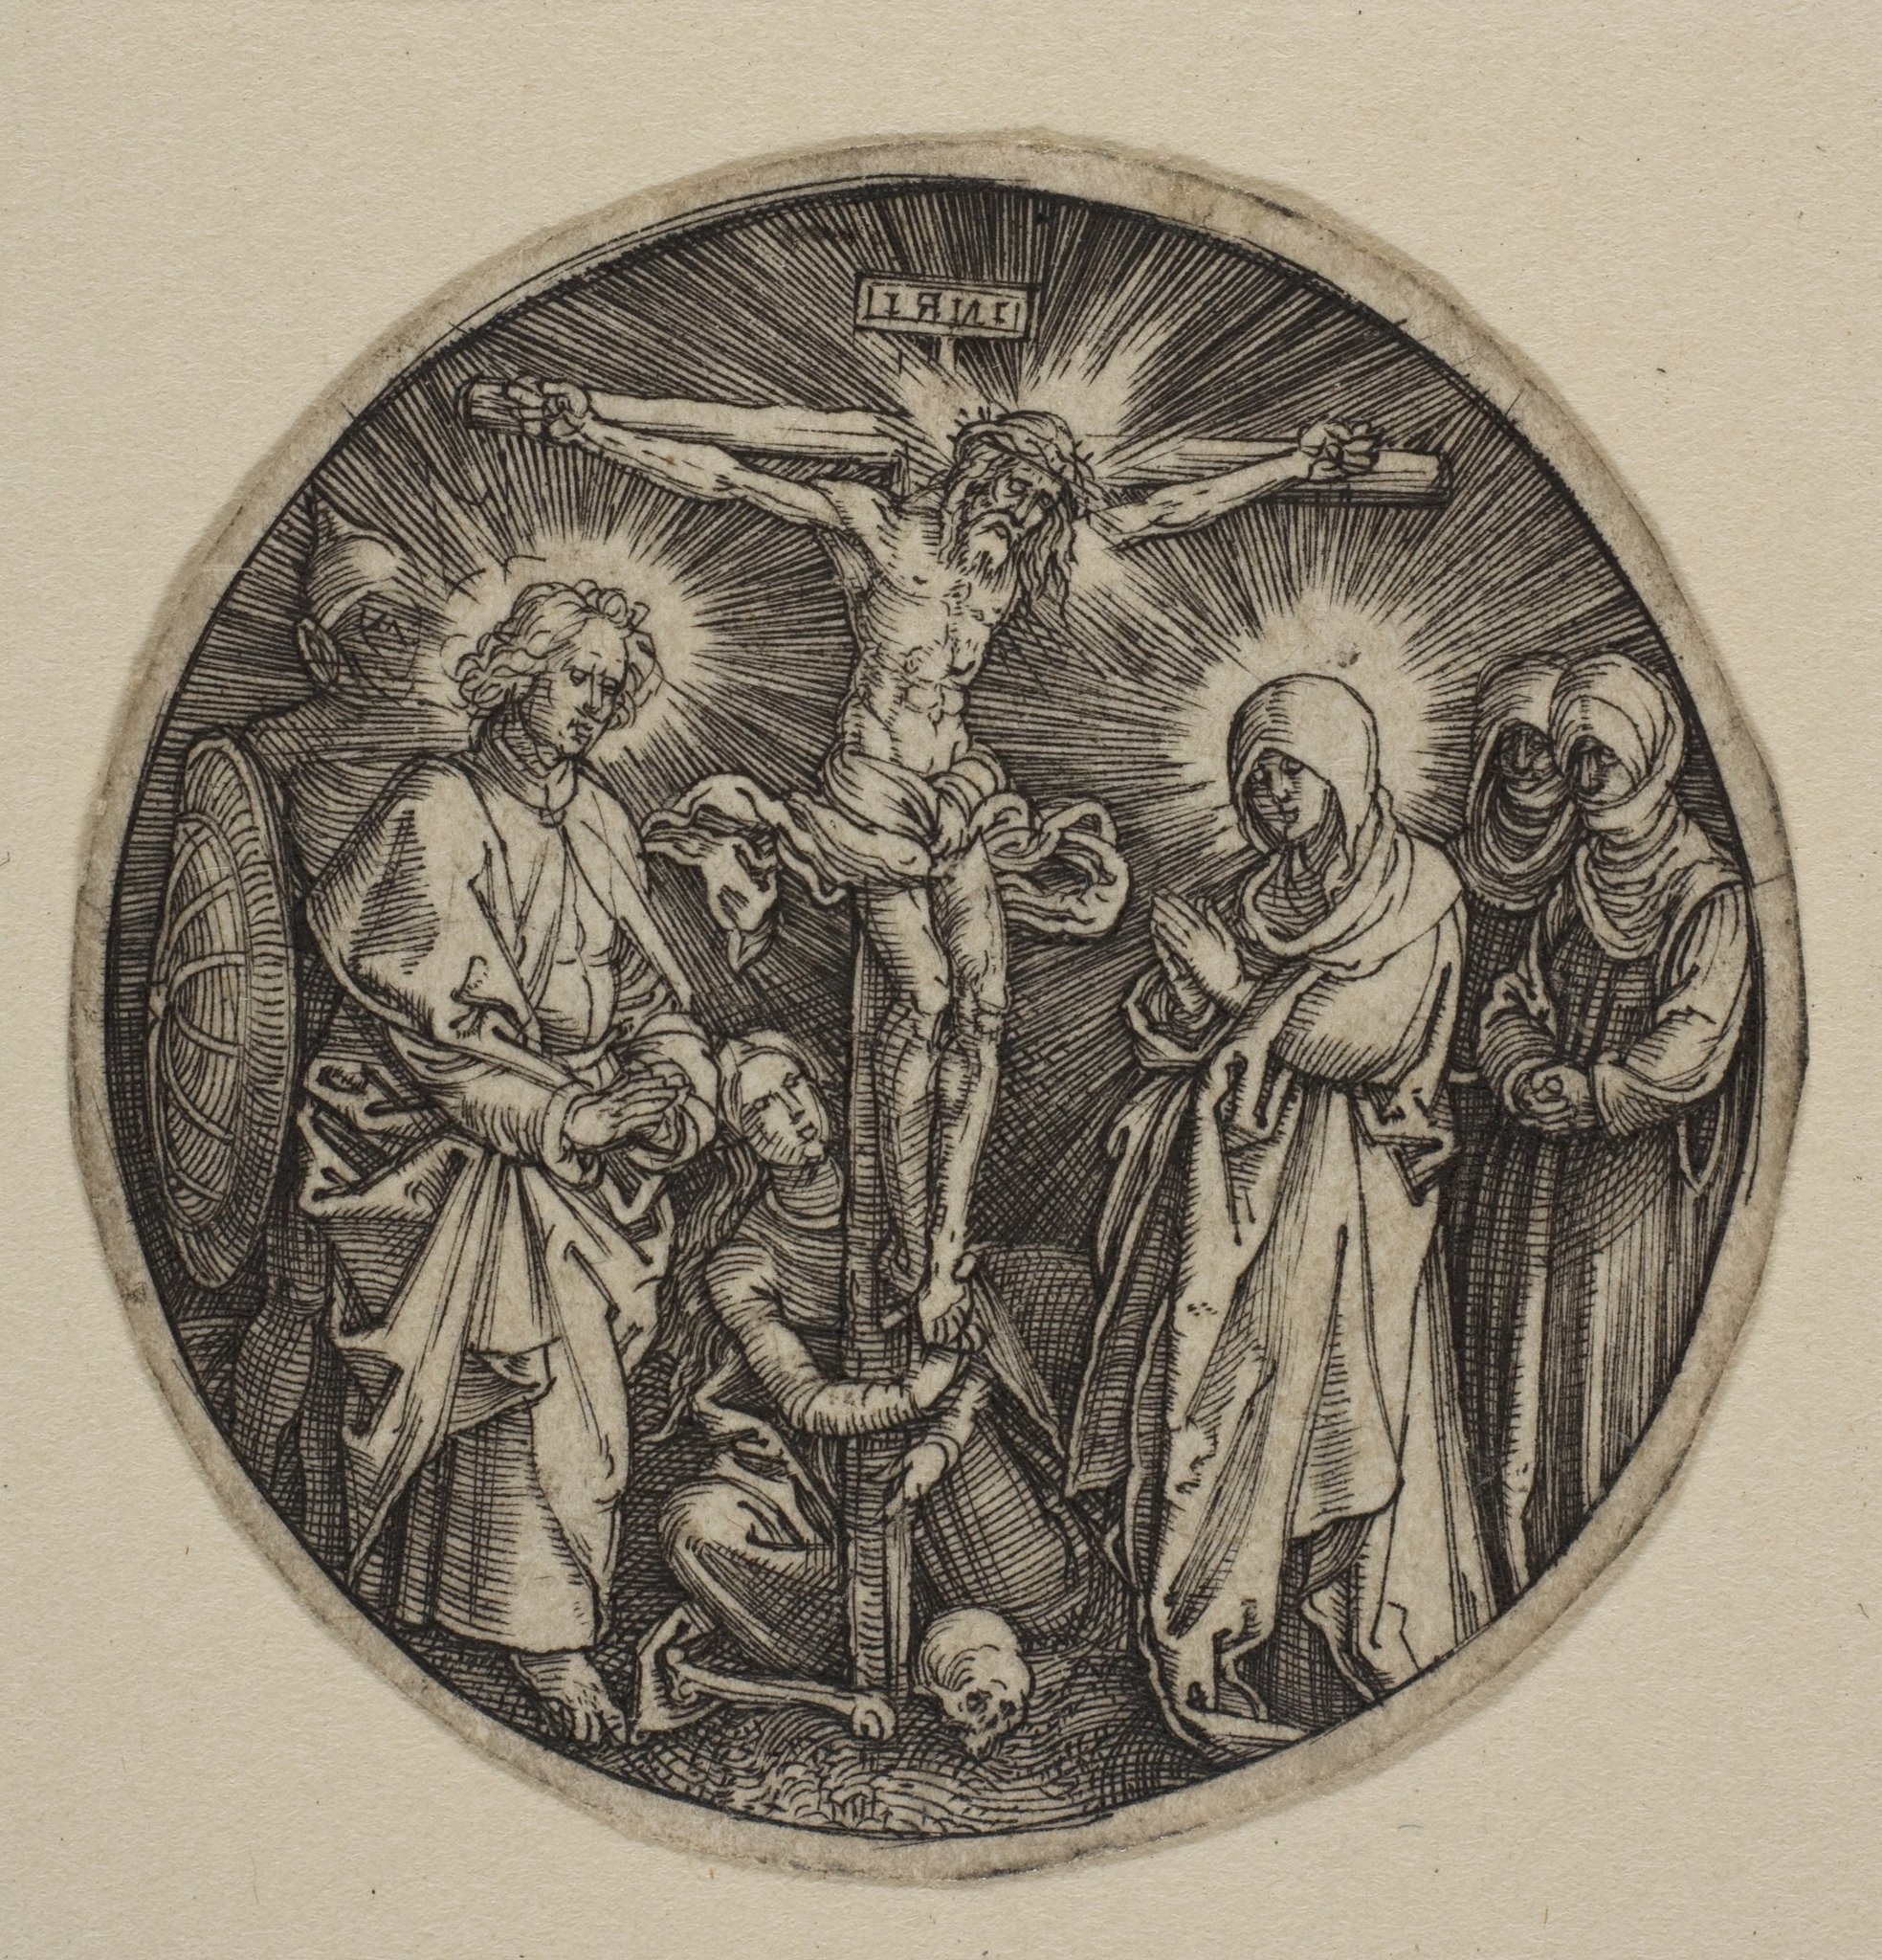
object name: print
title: The Crucifixion (Round)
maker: albrecht dürer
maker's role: artist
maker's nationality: german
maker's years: 1471-1528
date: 1519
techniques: engraving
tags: men,women,christ,cross,crucifixion